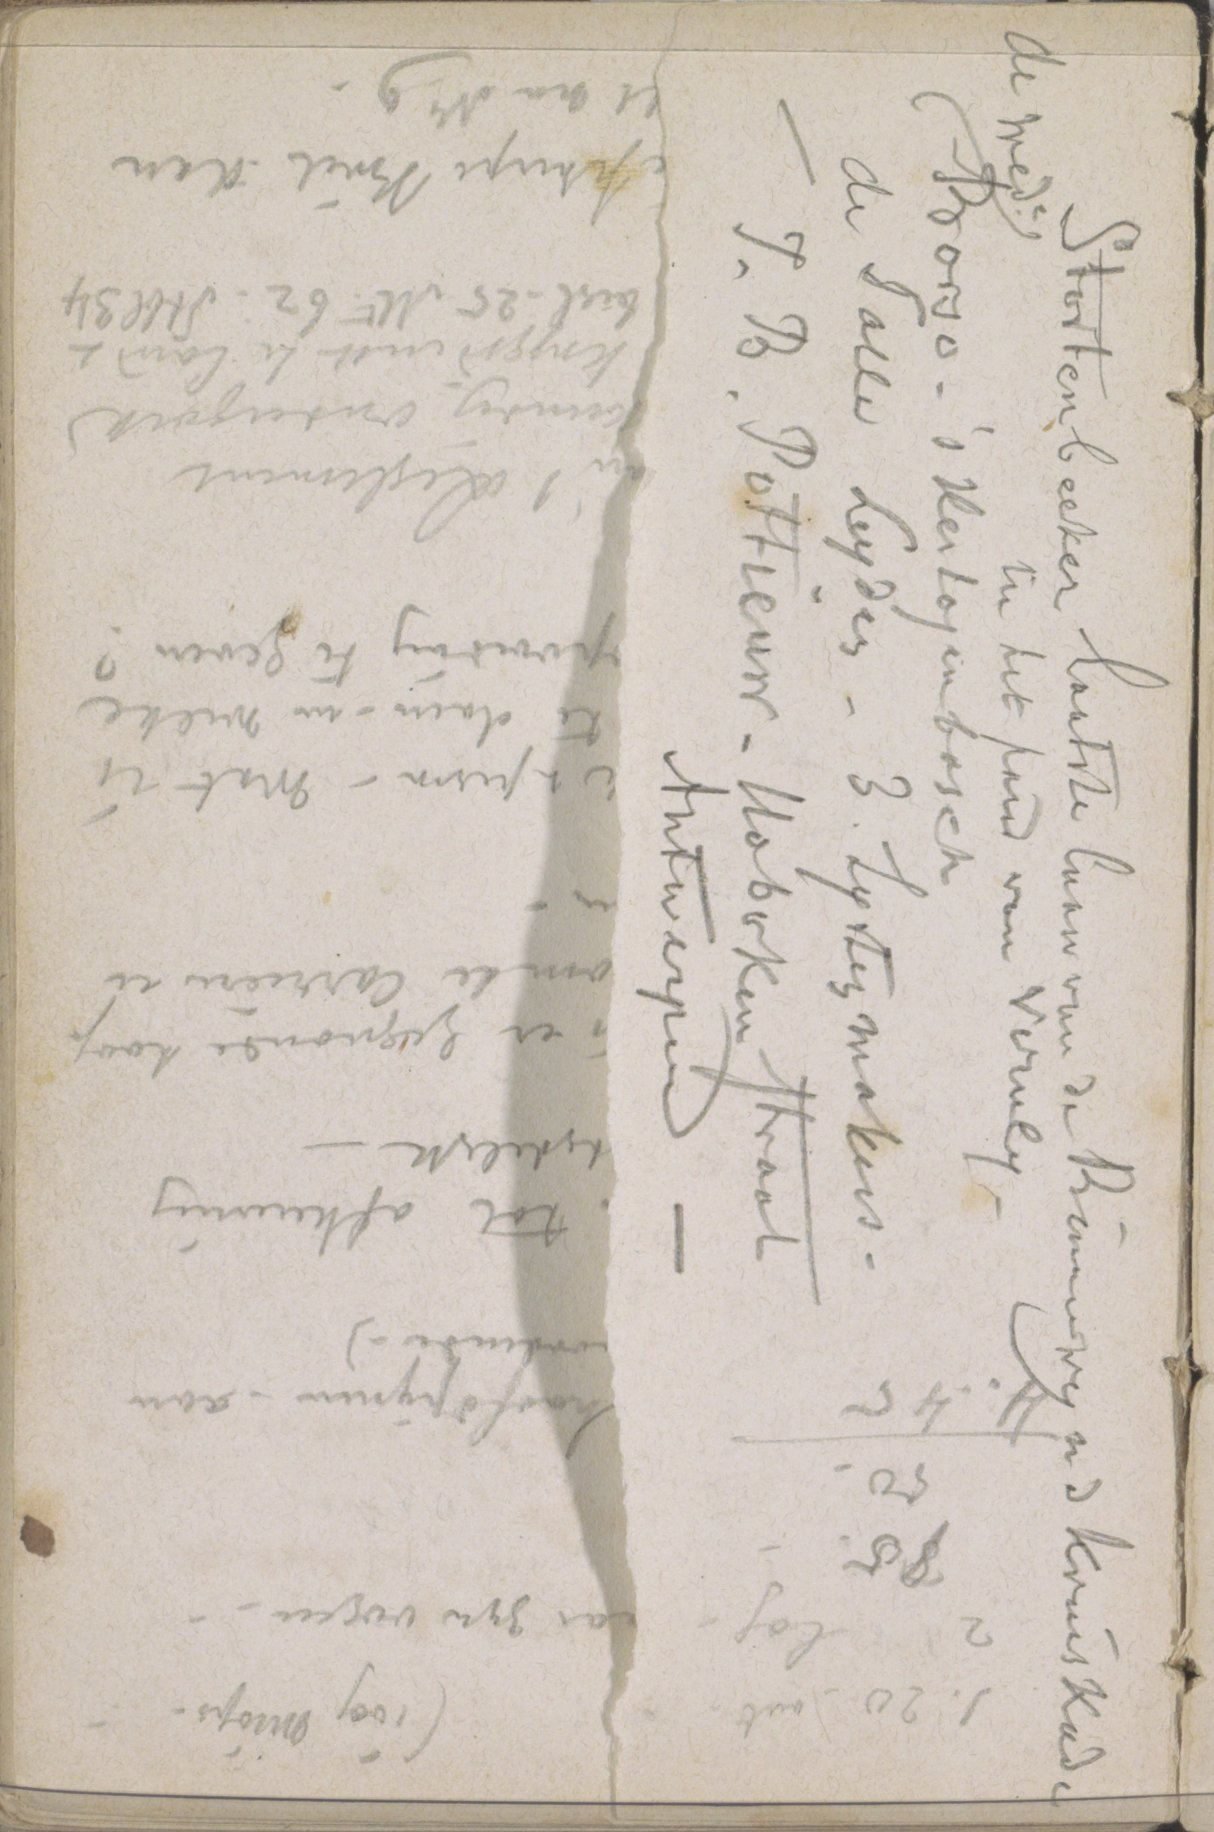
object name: sketchbook leaf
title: Adressen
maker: johannes tavenraat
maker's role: draughtsman, painter, print maker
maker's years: 1809-1881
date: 1862-1864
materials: paper, pencil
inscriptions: annotation: ‘Stortenbeeker laatste laan van de Binnenweg en de Kruiskade/ in het pand van Verwey/ [...] Borso - 's Hertogenbosch/ [...] J.B. Pottiew - Hoboken straat/ Antwerpen -’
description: Blad 58 verso uit een schetsboek met 65 bladen.